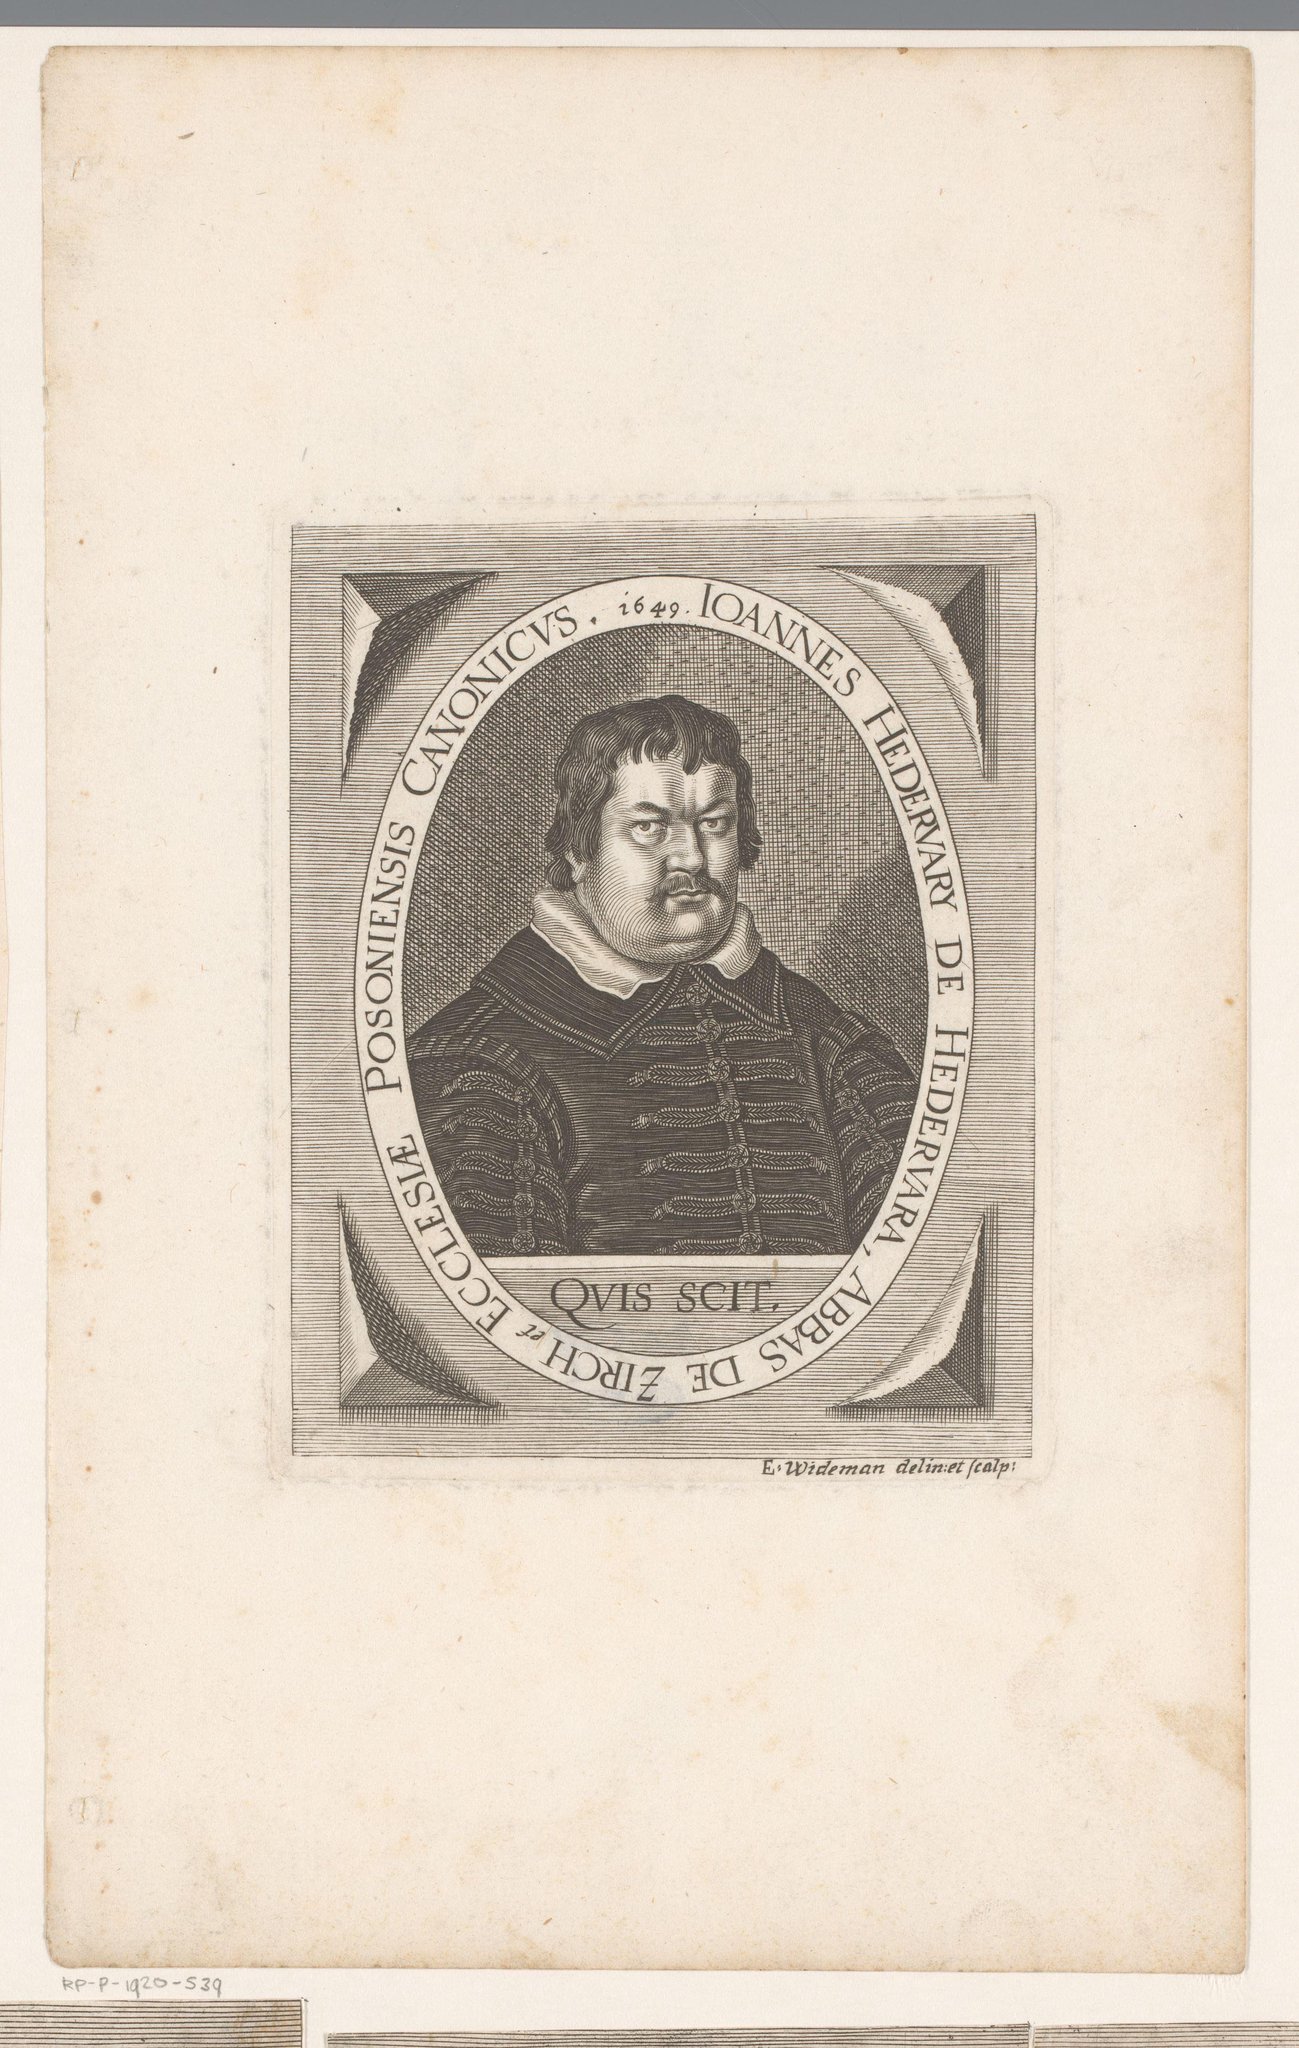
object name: print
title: Portret van János Hederváry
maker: elias widemann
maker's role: print maker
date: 1649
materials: paper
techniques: engraving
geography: vienna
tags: historical persons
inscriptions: collector's mark: Lugt 2228